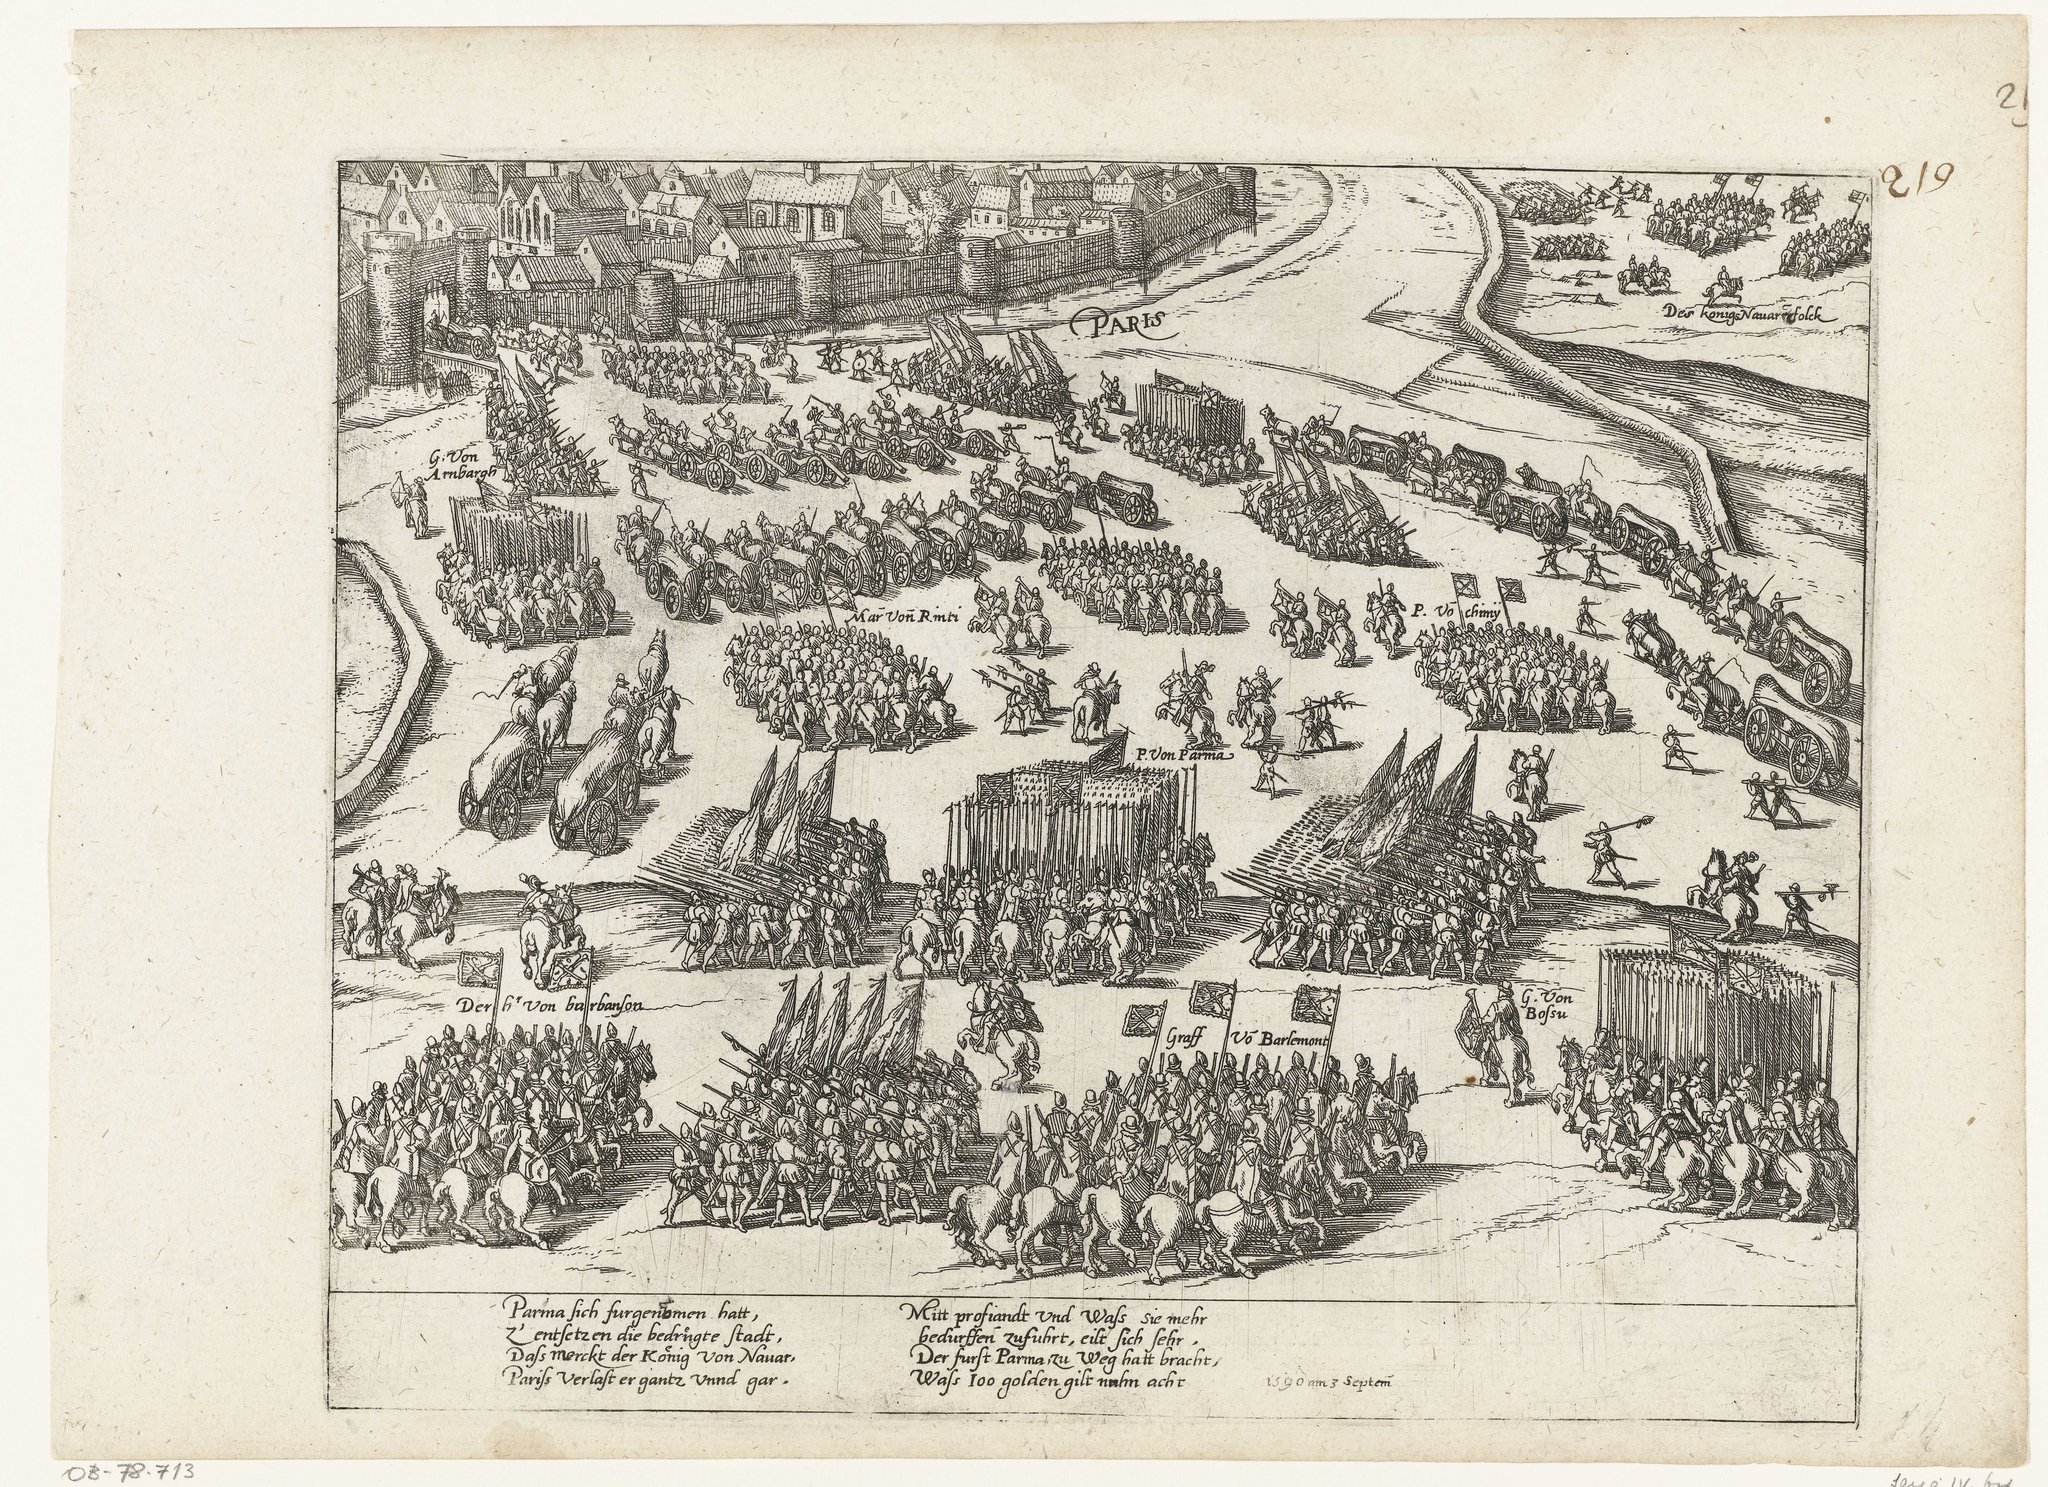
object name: print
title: Serie 4: Franse, Duitse en Engelse Gebeurtenissen, 1576-1610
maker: frans hogenberg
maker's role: print maker, publisher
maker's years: 1538-1590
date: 1590-1592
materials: paper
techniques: etching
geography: cologne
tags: rome, alessandro farnese (landvoogd van de nederlanden en hertog van parma en piacenza), paris, hendrik iv (koning van frankrijk en navarra), communication and transport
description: Parijs van proviand voorzien door de hertog van Parma, 3 september 1590. Op de voorgrond de o.a. Nederlandse troepen onder bevel van Parma en wagens met proviand die naar de stad optrekken, in de verte de muren van de stad. Met onderschrift van 8 regels in het Duits. Ongenummerd. Blad afkomstig uit een album dat uit elkaar is gehaald. Rechtsboven genummerd (in pen): 219.